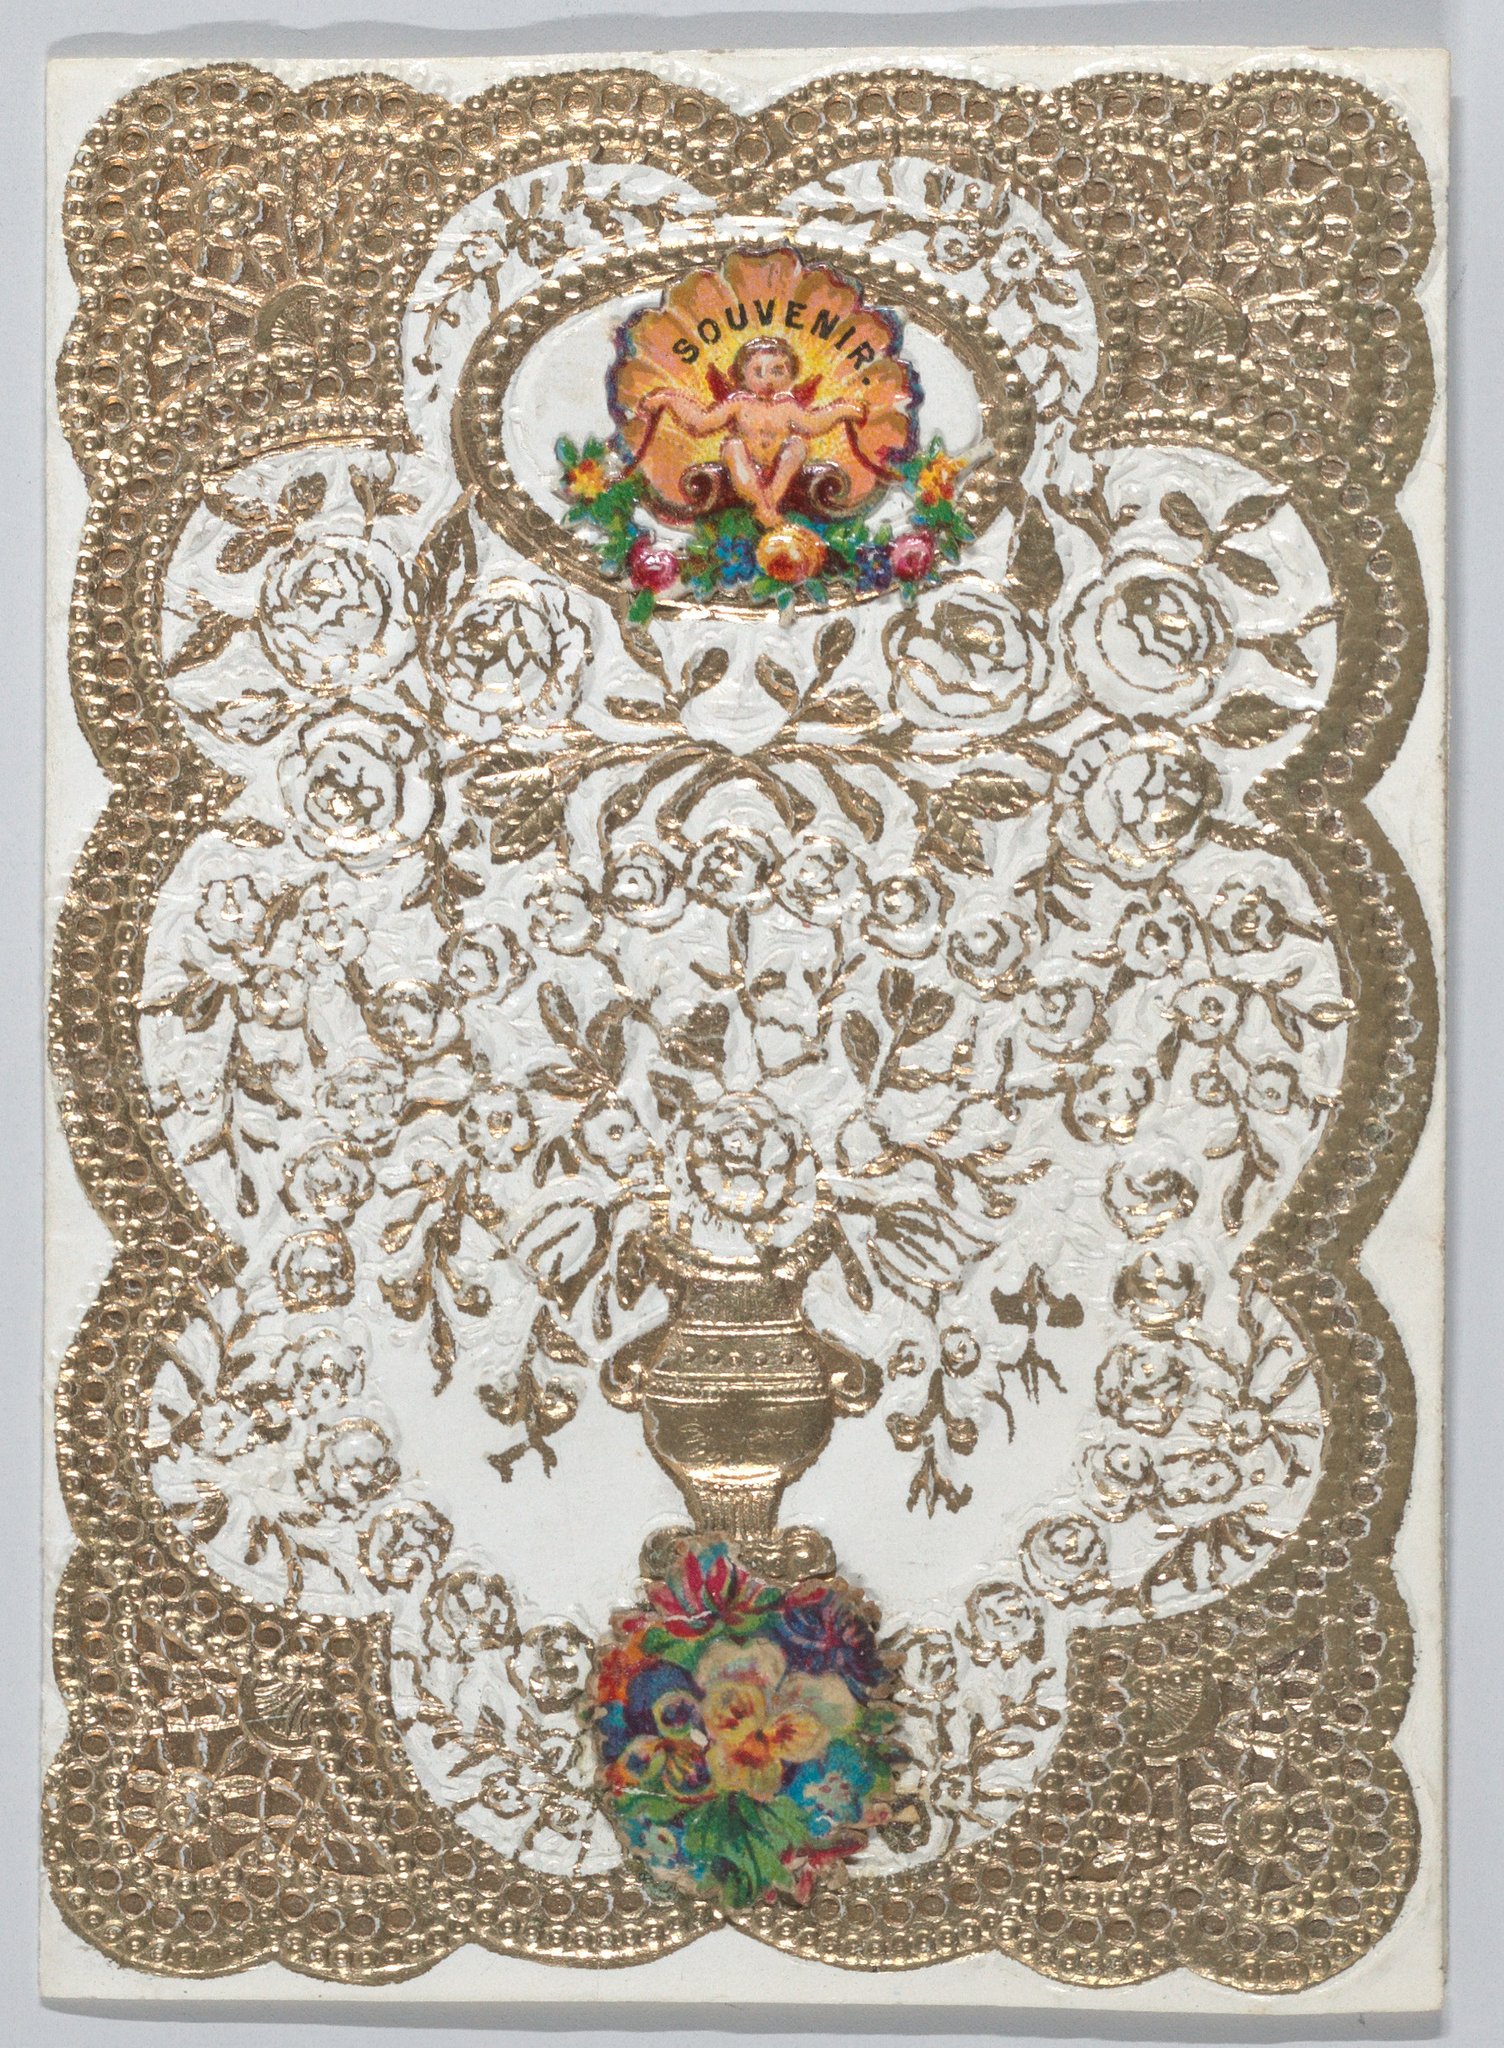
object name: valentine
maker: Anonymous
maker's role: artist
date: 1850-1860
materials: lace, paper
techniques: chromolithography, embossing, gilding